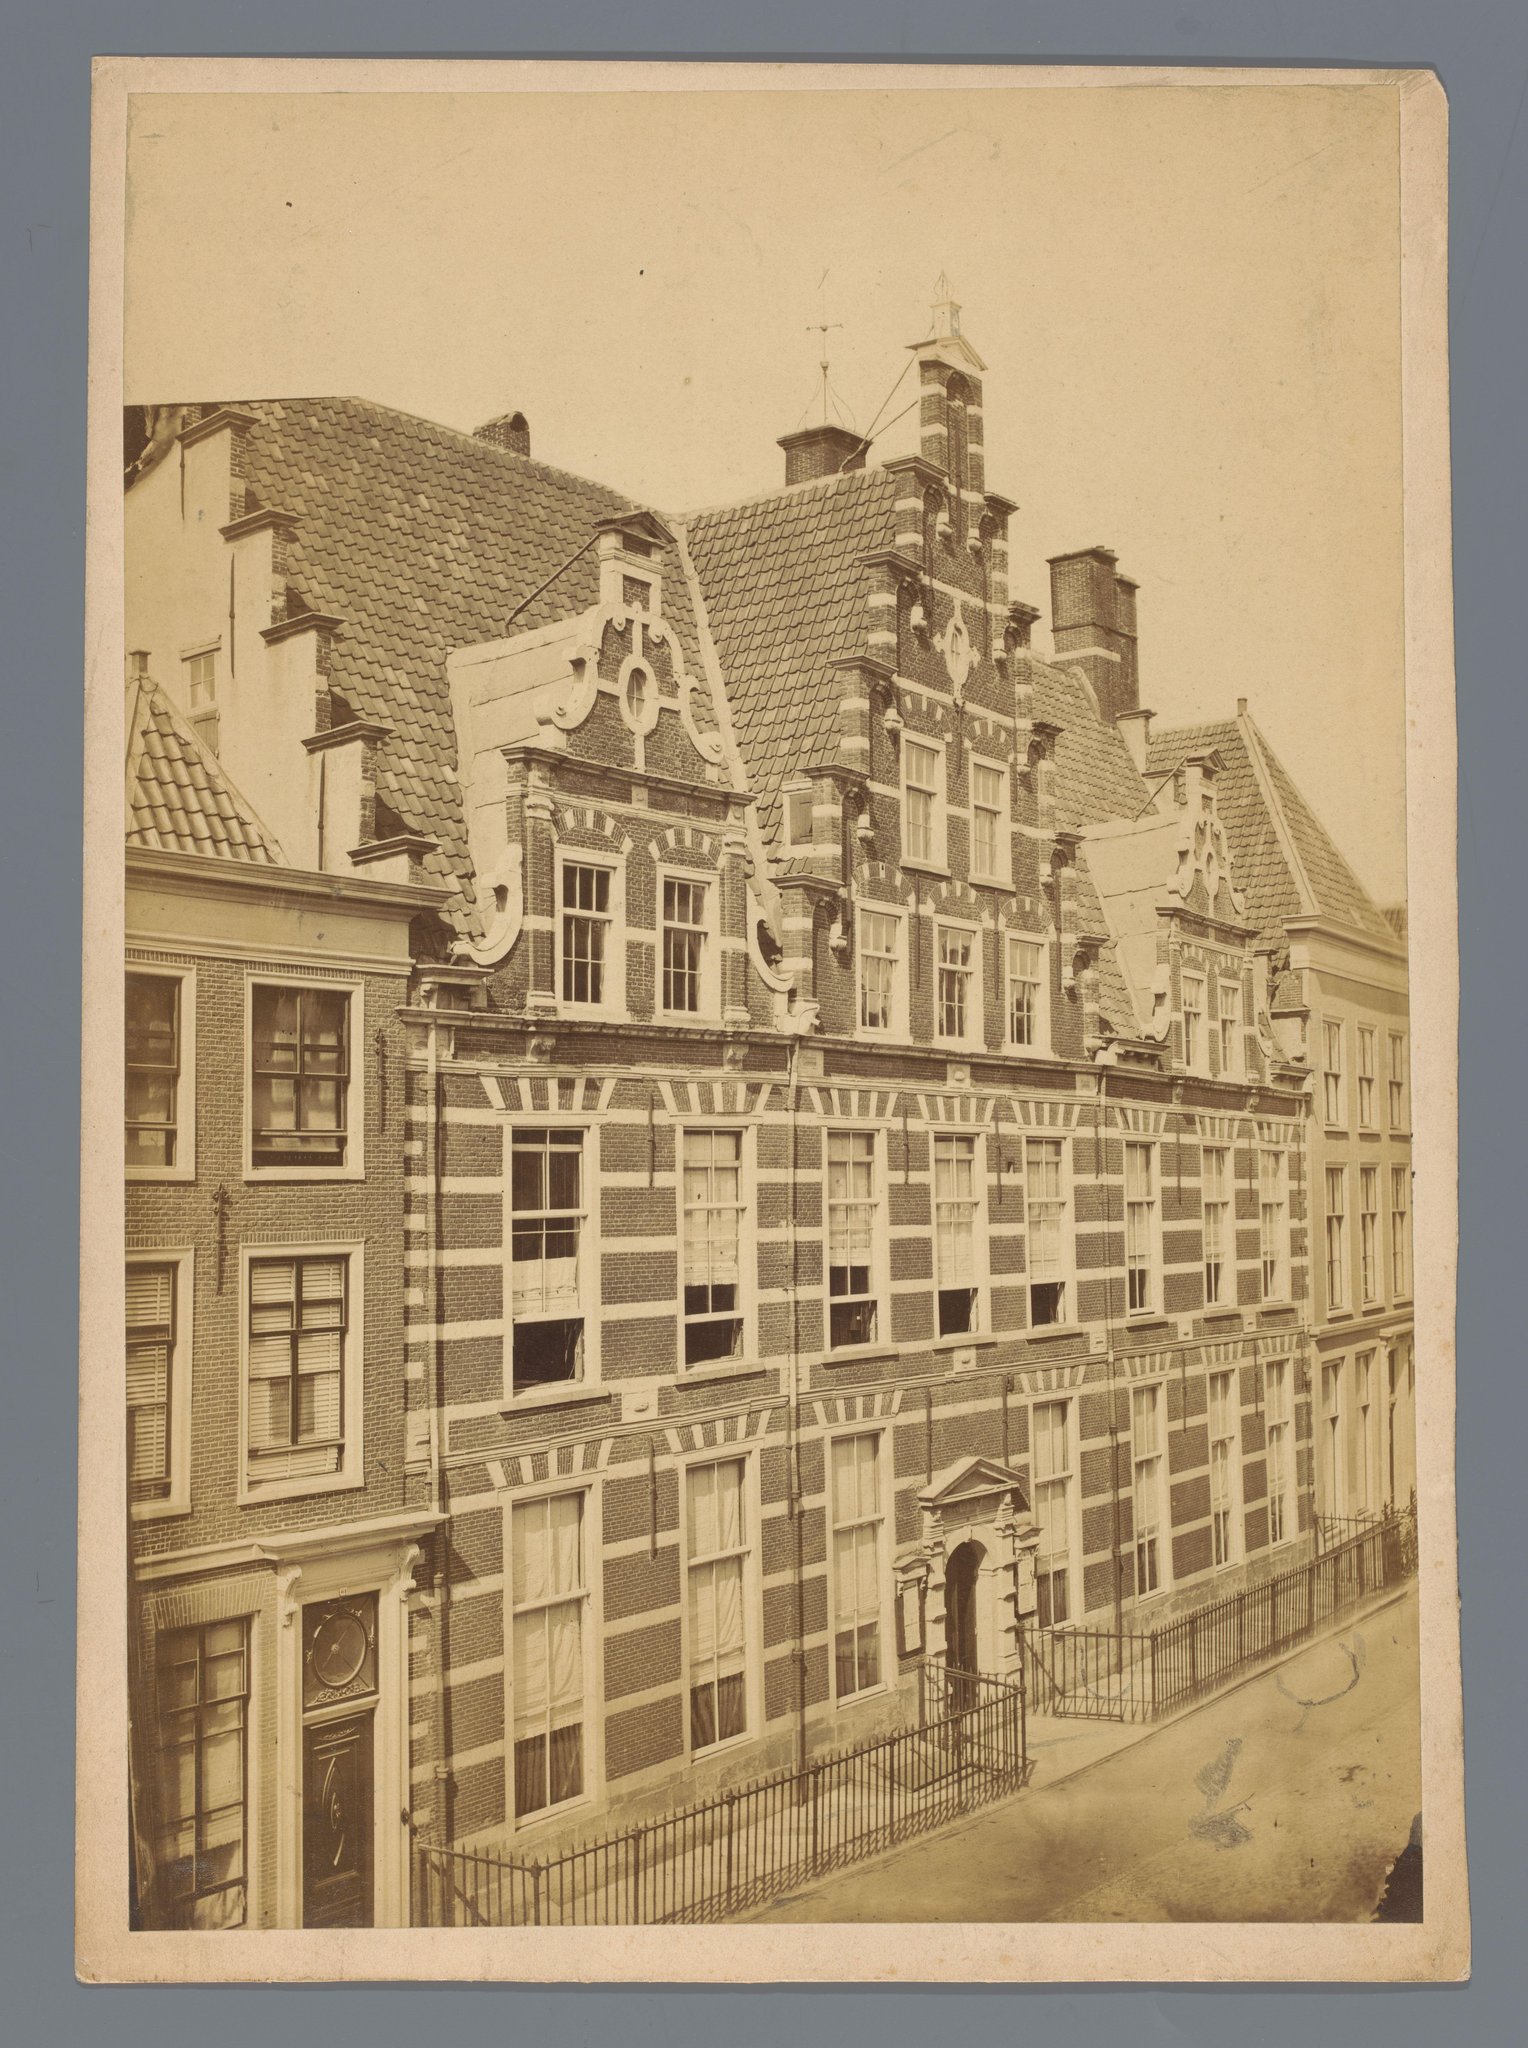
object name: photograph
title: Het Rijnlandhuis in Leiden, voorzien van een trapgevel en een stenen poort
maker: Anonymous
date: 1850-1900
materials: paper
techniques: albumen print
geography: netherlands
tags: urban housing, front façade, leiden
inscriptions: title: ‘Leiden, Rijnlandhuis’